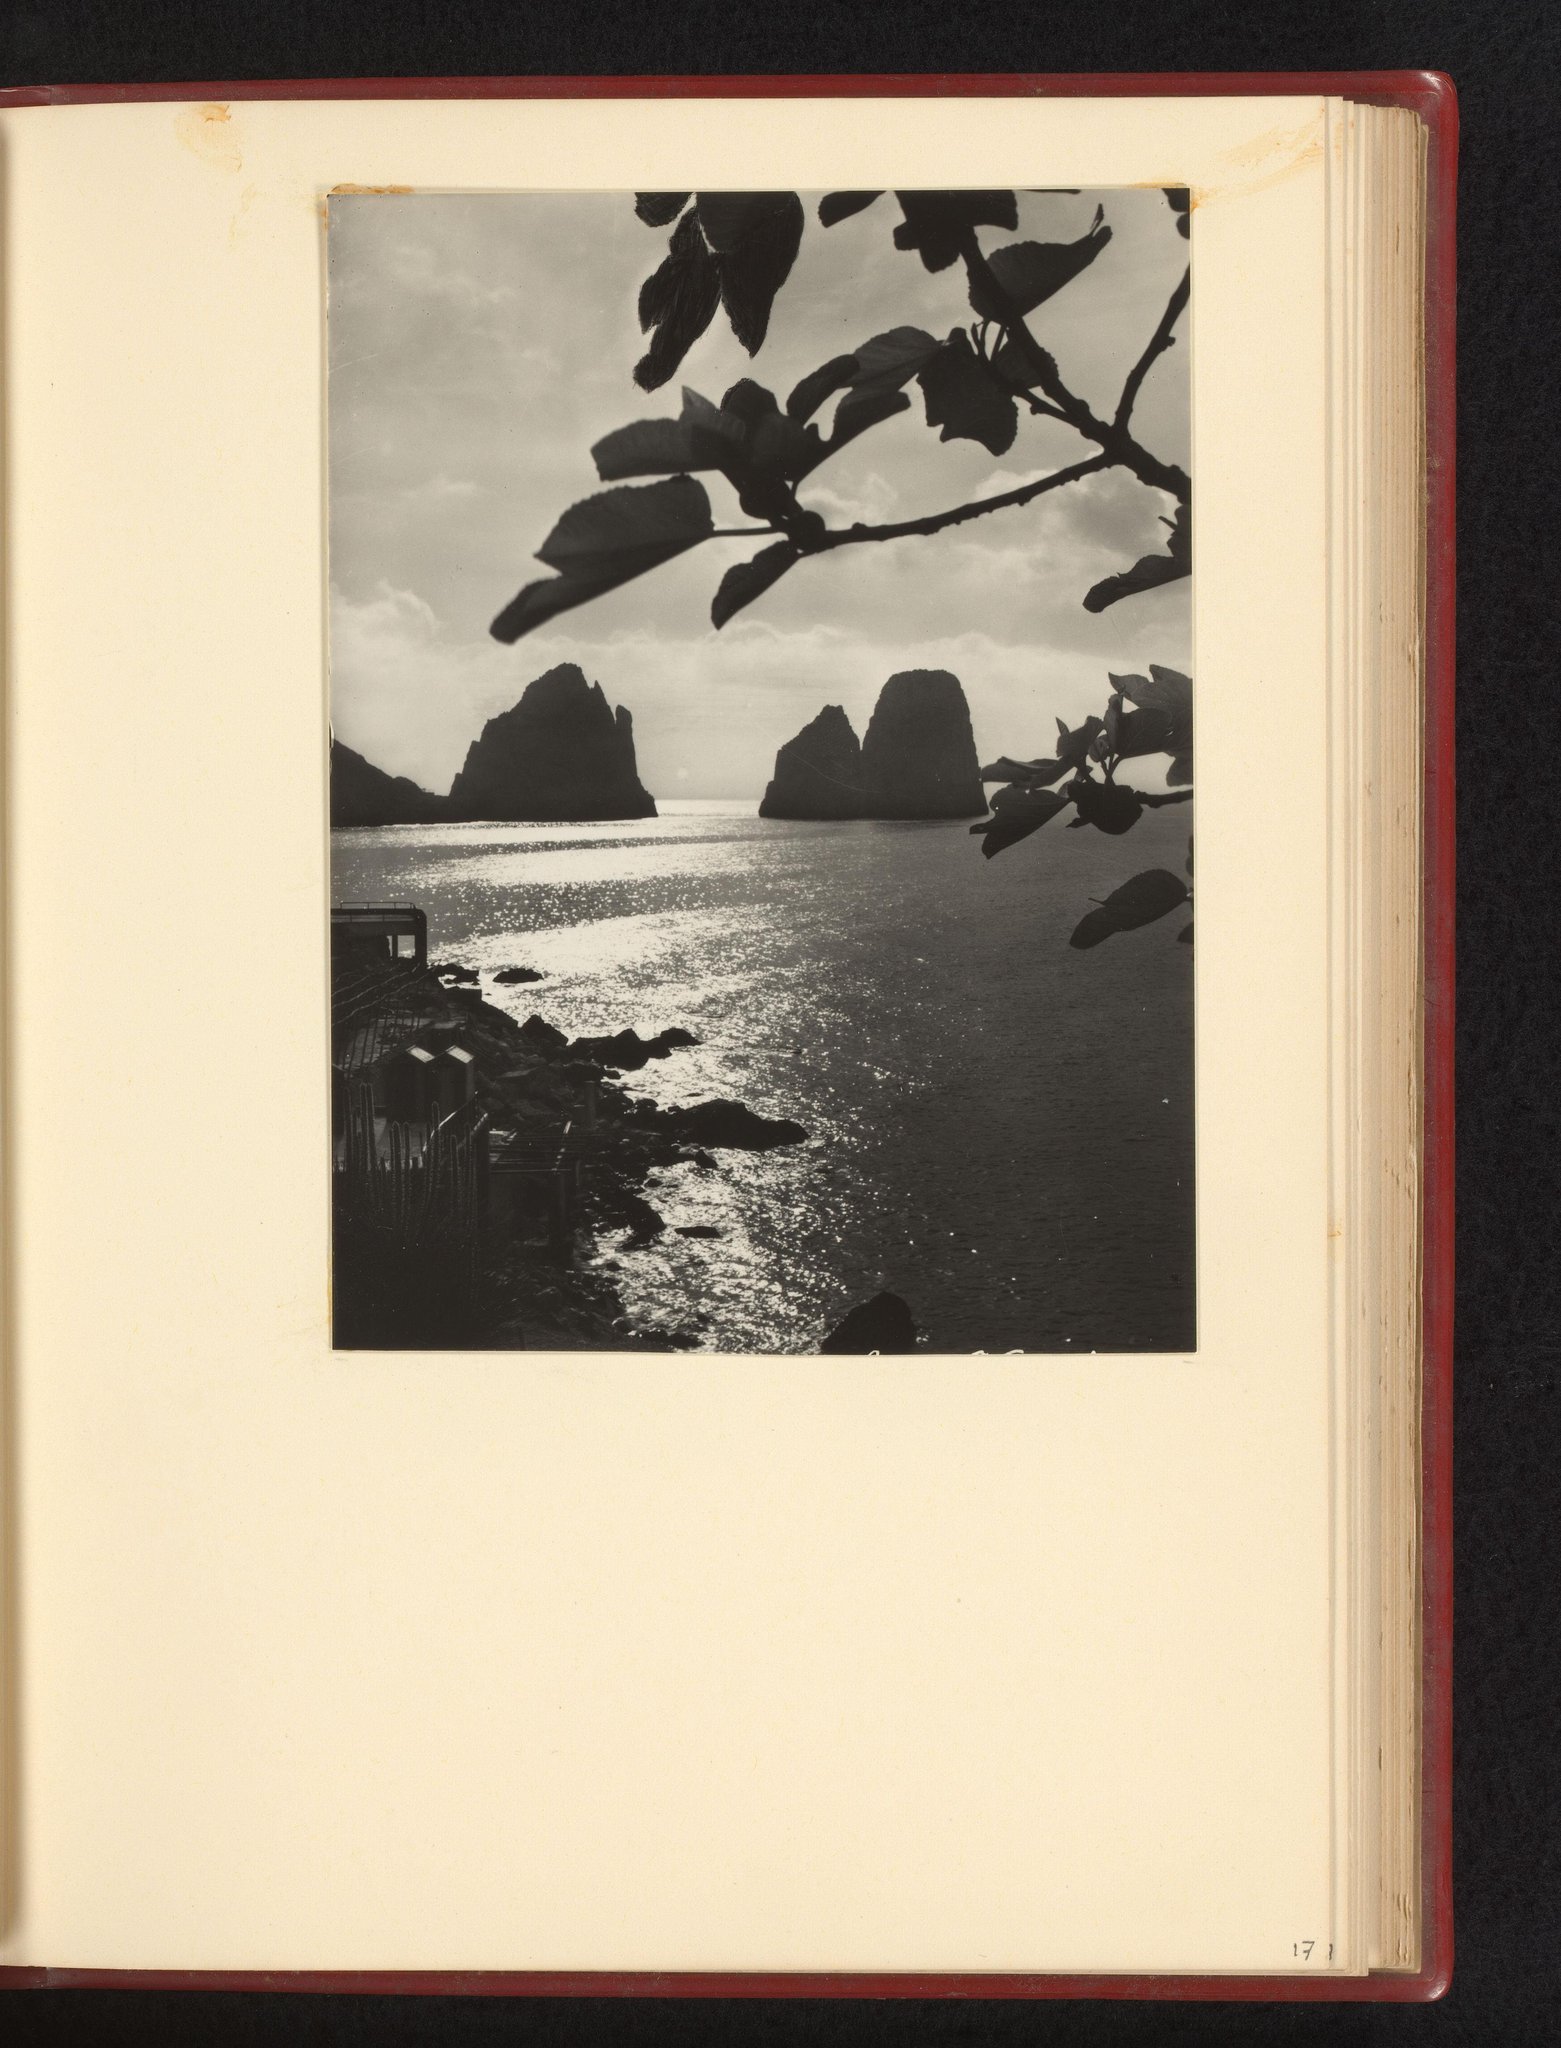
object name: album leaf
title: Gezicht op de Faraglioni di Capri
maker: Anonymous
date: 1954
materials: paper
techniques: gelatin silver print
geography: capri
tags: gulf, bay, rock-formations